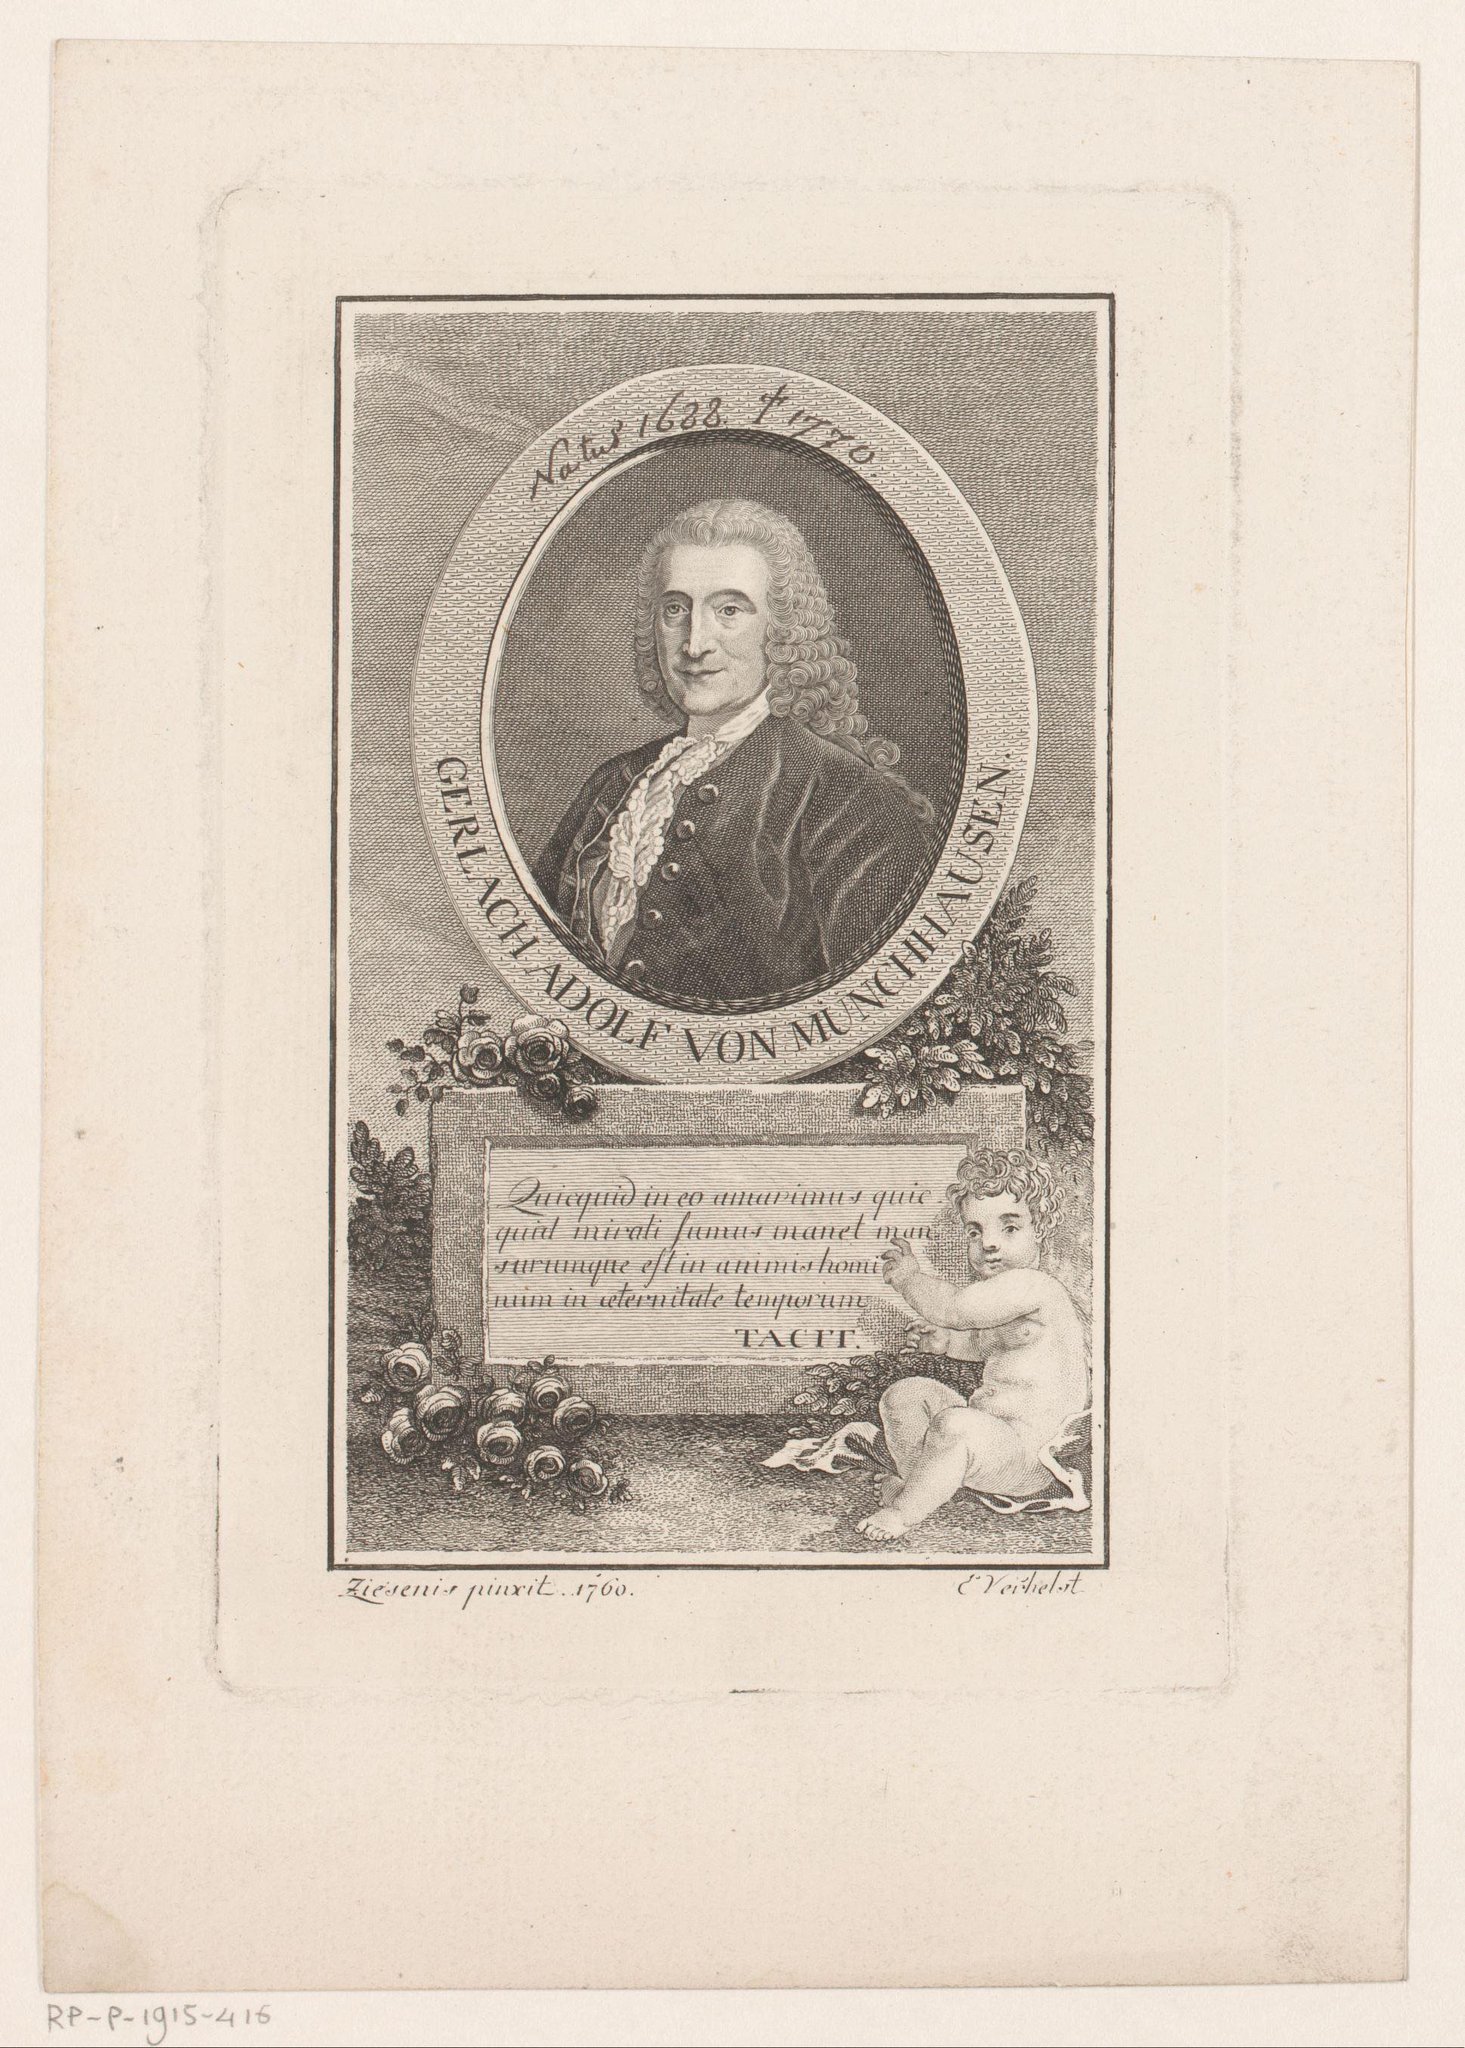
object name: print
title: Portret van Gerlach Adolph von Münchhausen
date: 1743-1818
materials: paper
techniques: engraving, etching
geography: germany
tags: berlin, historical persons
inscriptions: collector's mark: Lugt 2228, inscription: ‘Natus 1688 † 1770’